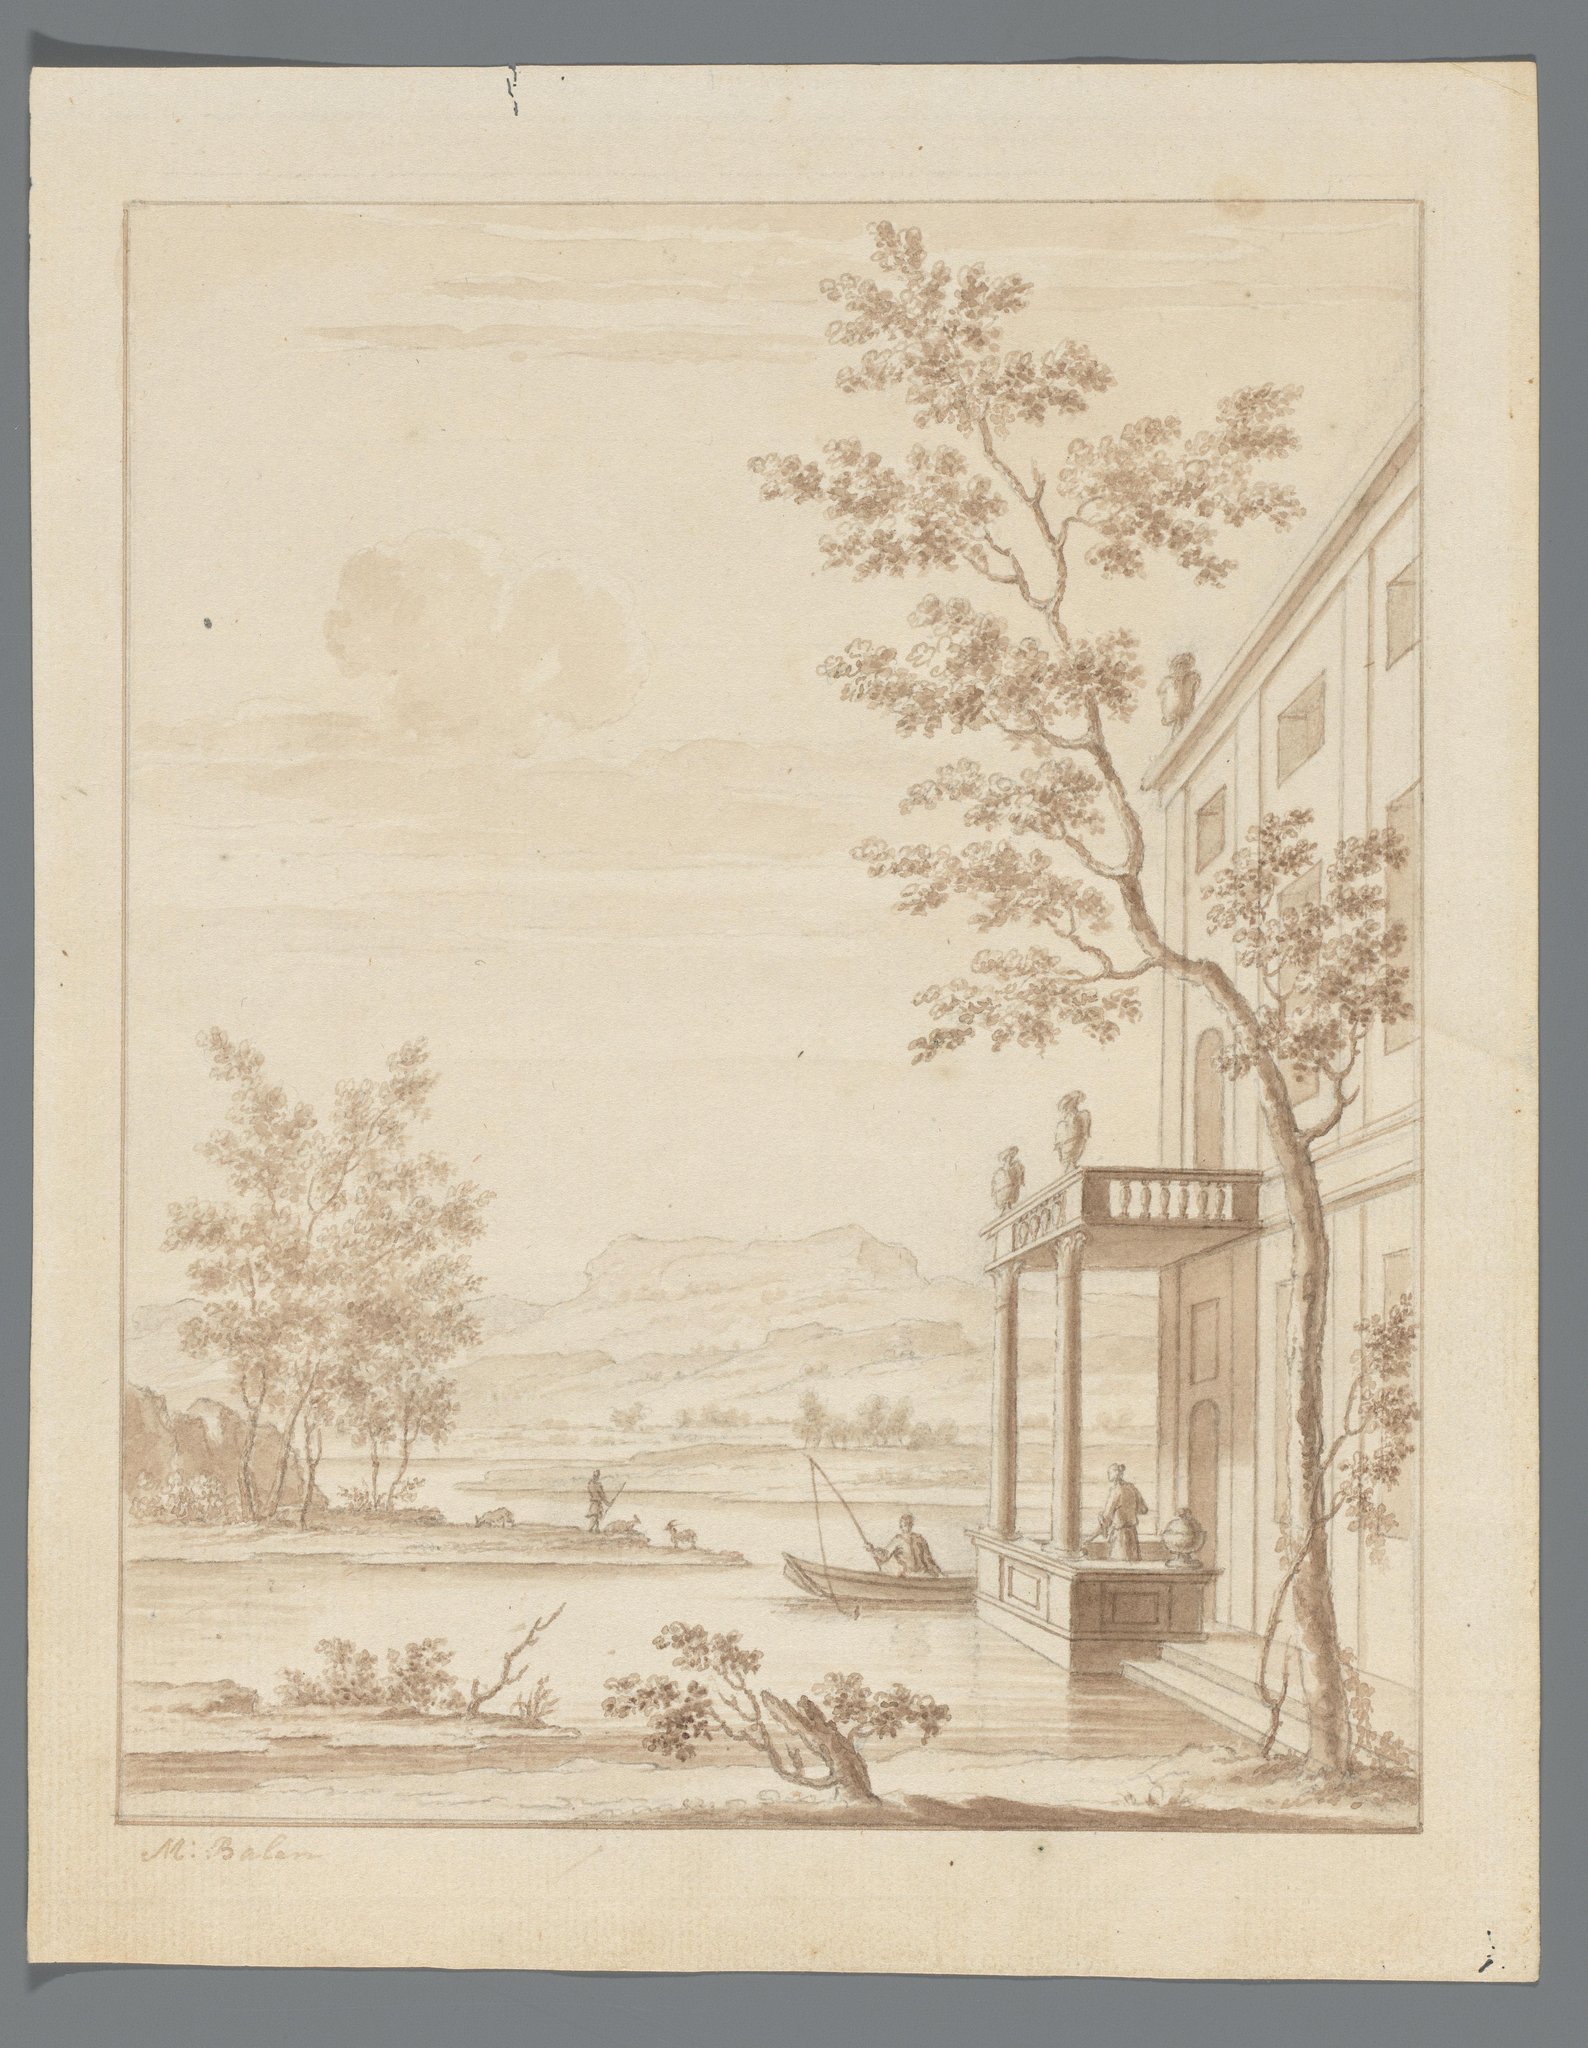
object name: drawing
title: Gezicht op een gebouw aan het water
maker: matthijs balen (1684-1766)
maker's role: draughtsman, painter, print maker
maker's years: 1684-1766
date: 1694-1766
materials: paper, pencil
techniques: brush, pen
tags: city-view, and landscape with man-made constructions, rural housing, e.g. country-house, villa, cottage, fisherman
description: Mogelijk een ontwerp voor (een deel van) een behangstrook.